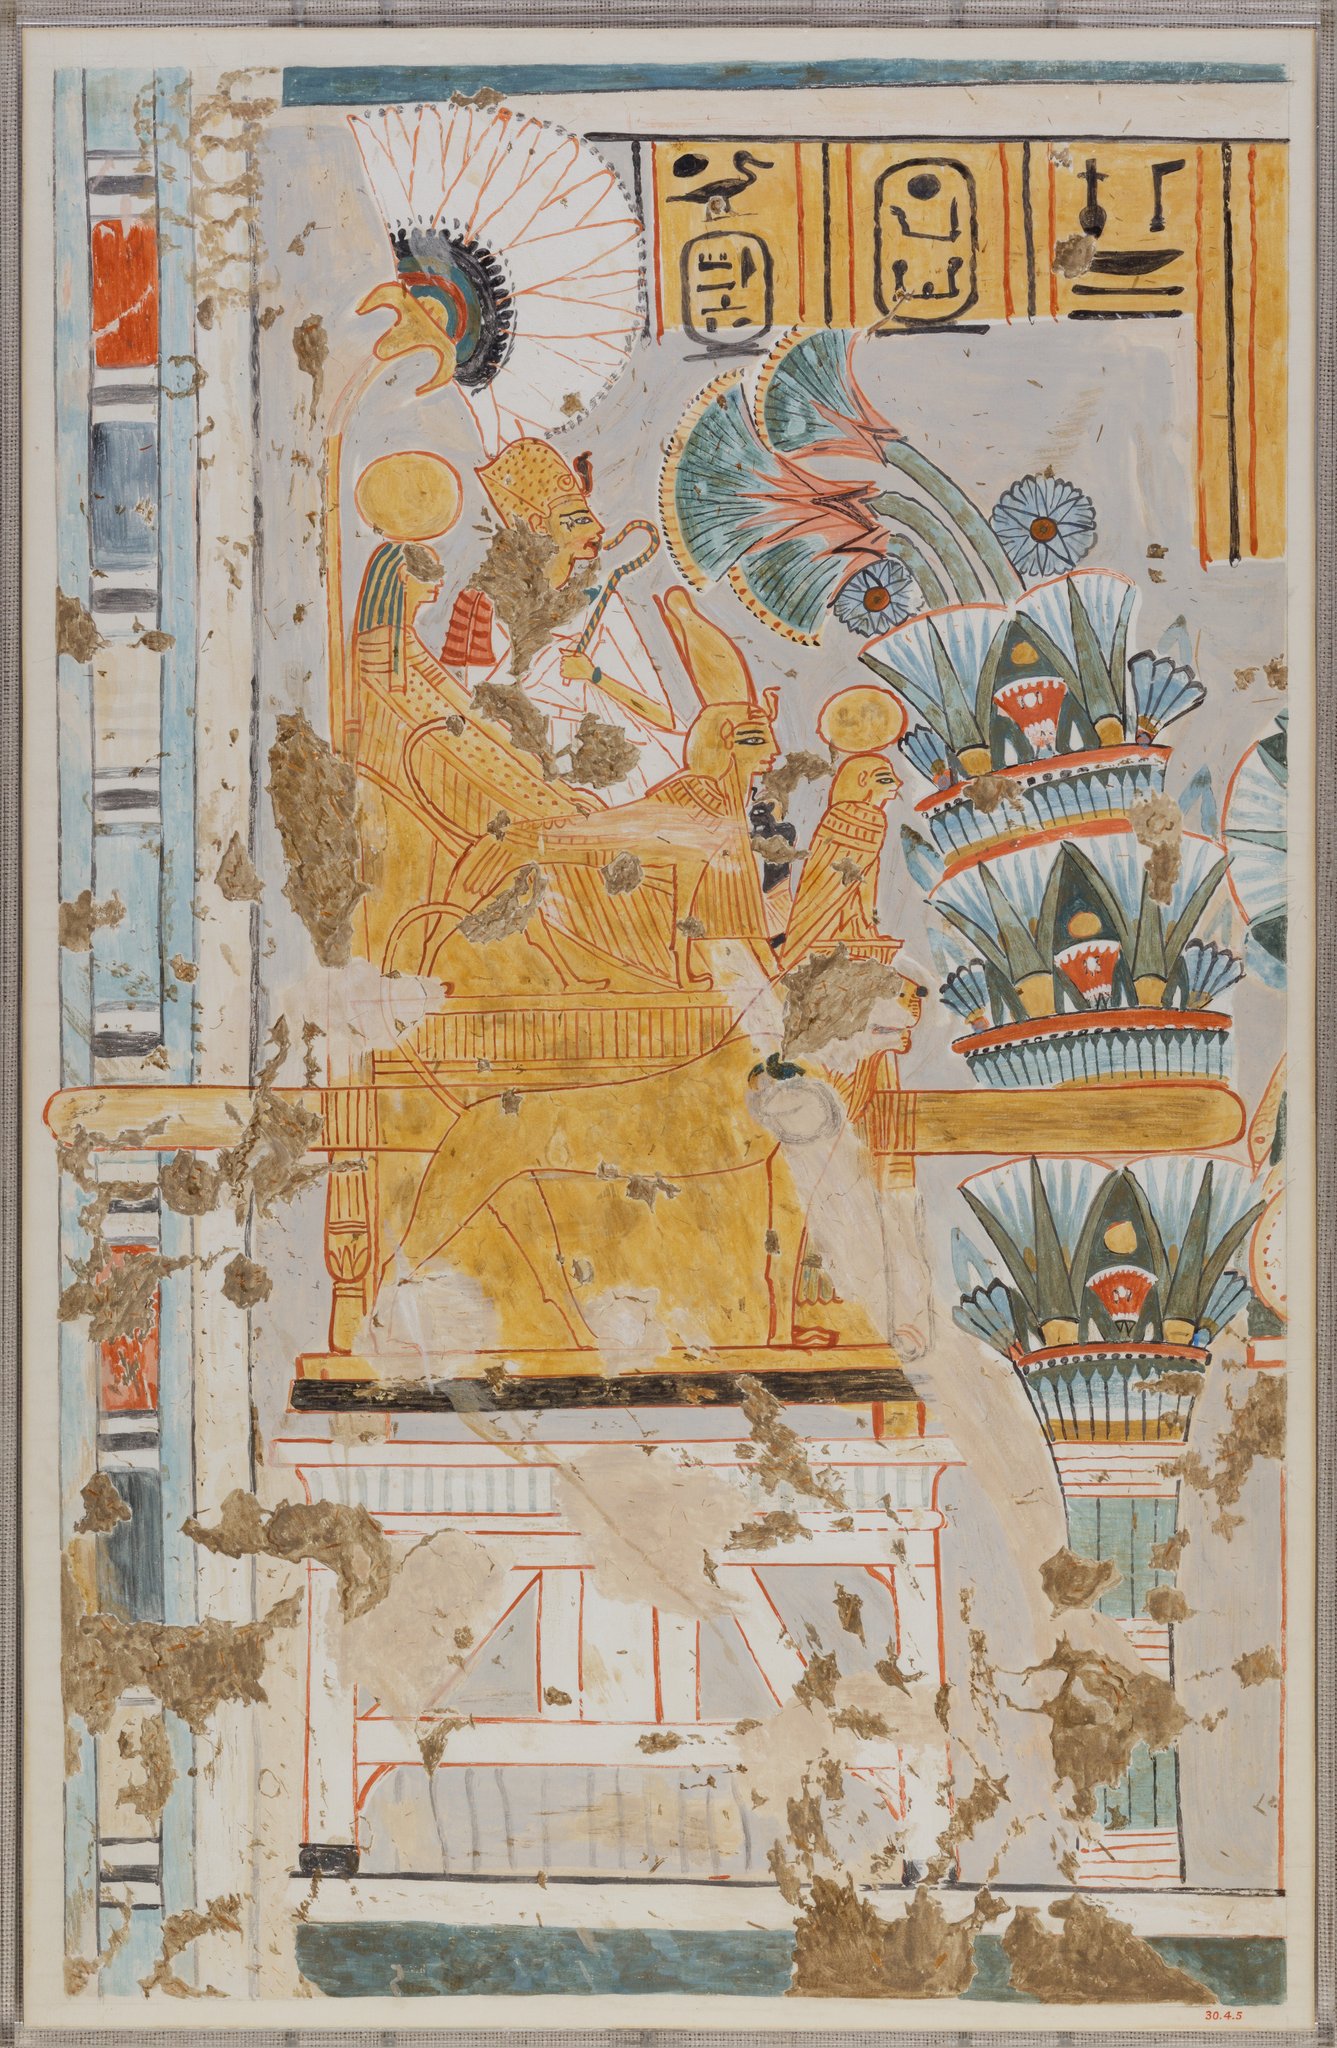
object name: facsimile, panehsy tt 16, amenhotep i, palanquin, sphinx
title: Statue of Deified Amenhotep I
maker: nina de garis davies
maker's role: artist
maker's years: 1881-1965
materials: paper, paint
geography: egypt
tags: drink-and-be-merry